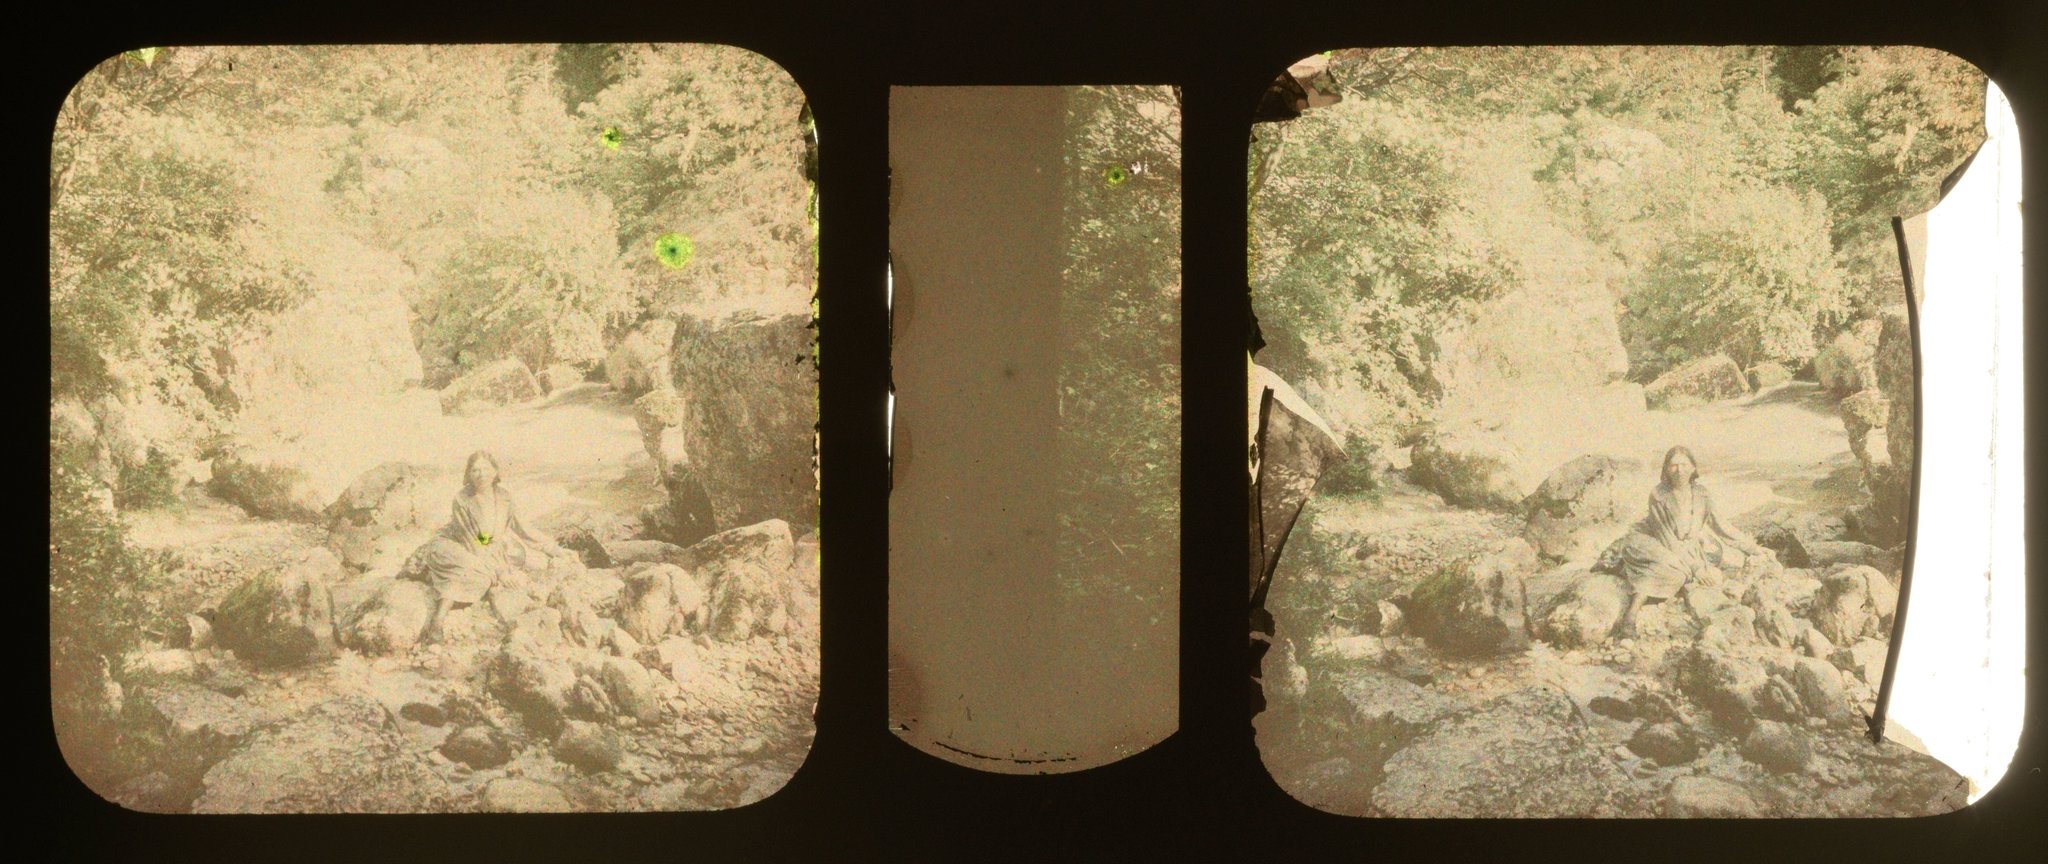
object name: stereoscopic photograph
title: Vrouw, zittend op rotsen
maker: adolphe burdet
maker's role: fotograaf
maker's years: 1860-1940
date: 1907-1935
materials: glass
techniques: autochrome process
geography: switzerland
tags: adult woman, rocks, switzerland